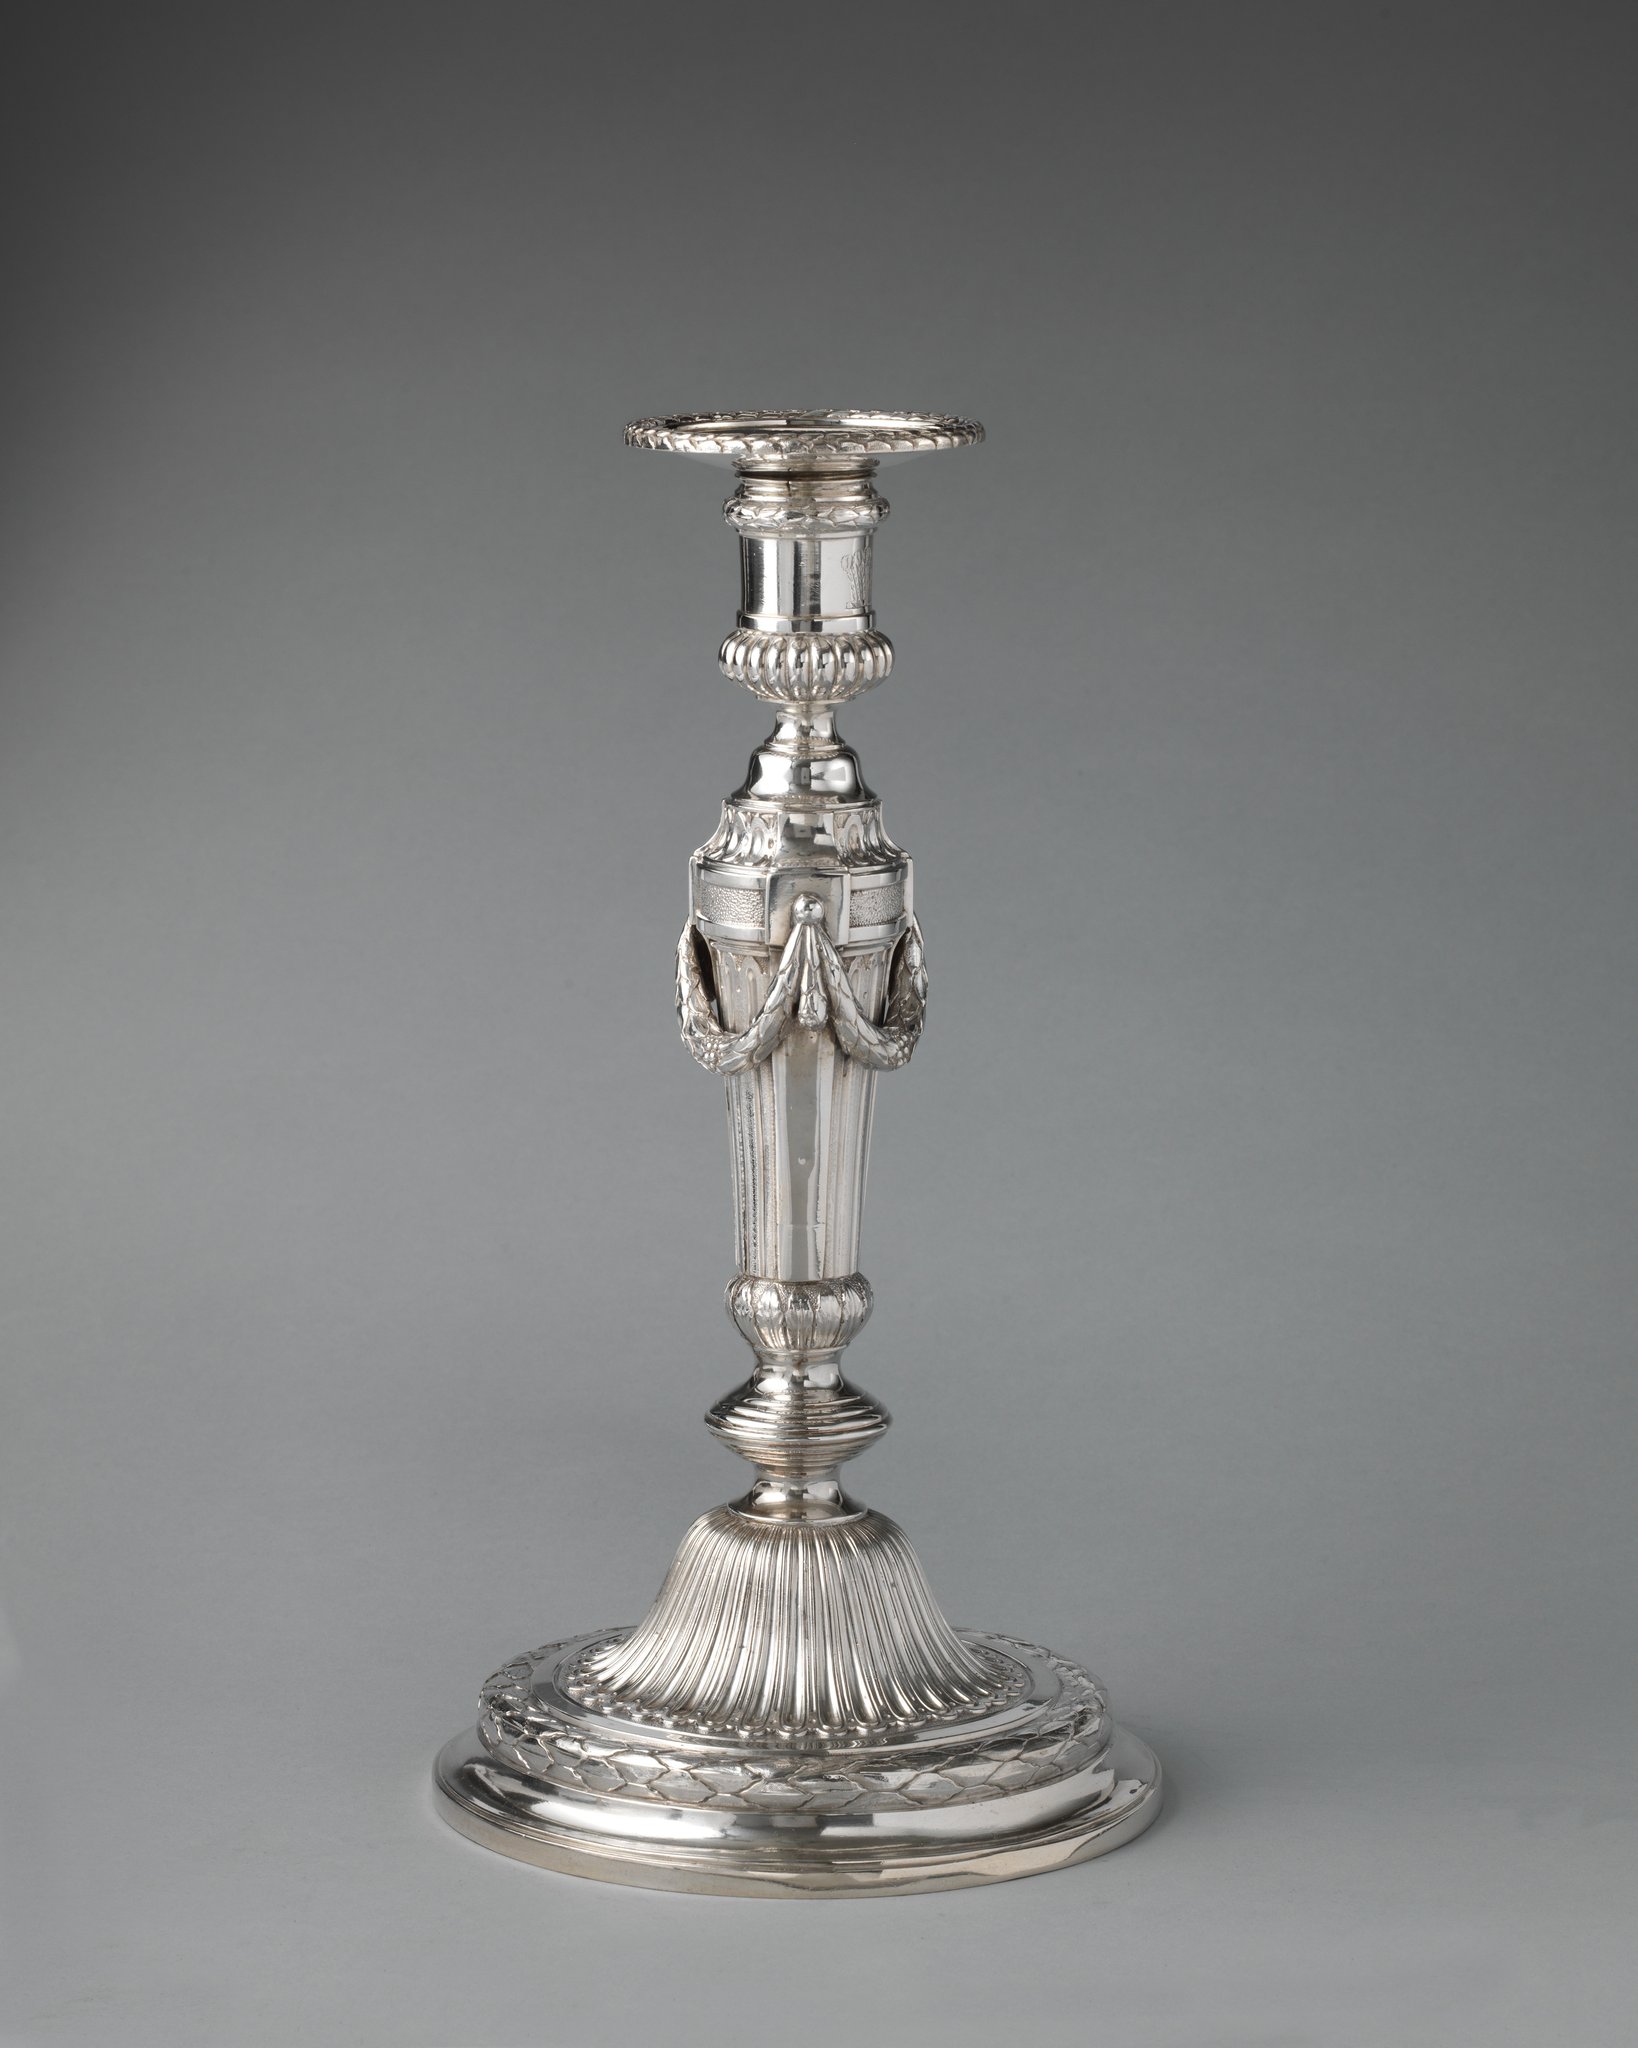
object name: candlestick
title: Candlestick (one of a set of eight)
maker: john romer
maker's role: maker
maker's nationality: british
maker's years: 1712-1815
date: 1768-1769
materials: silver